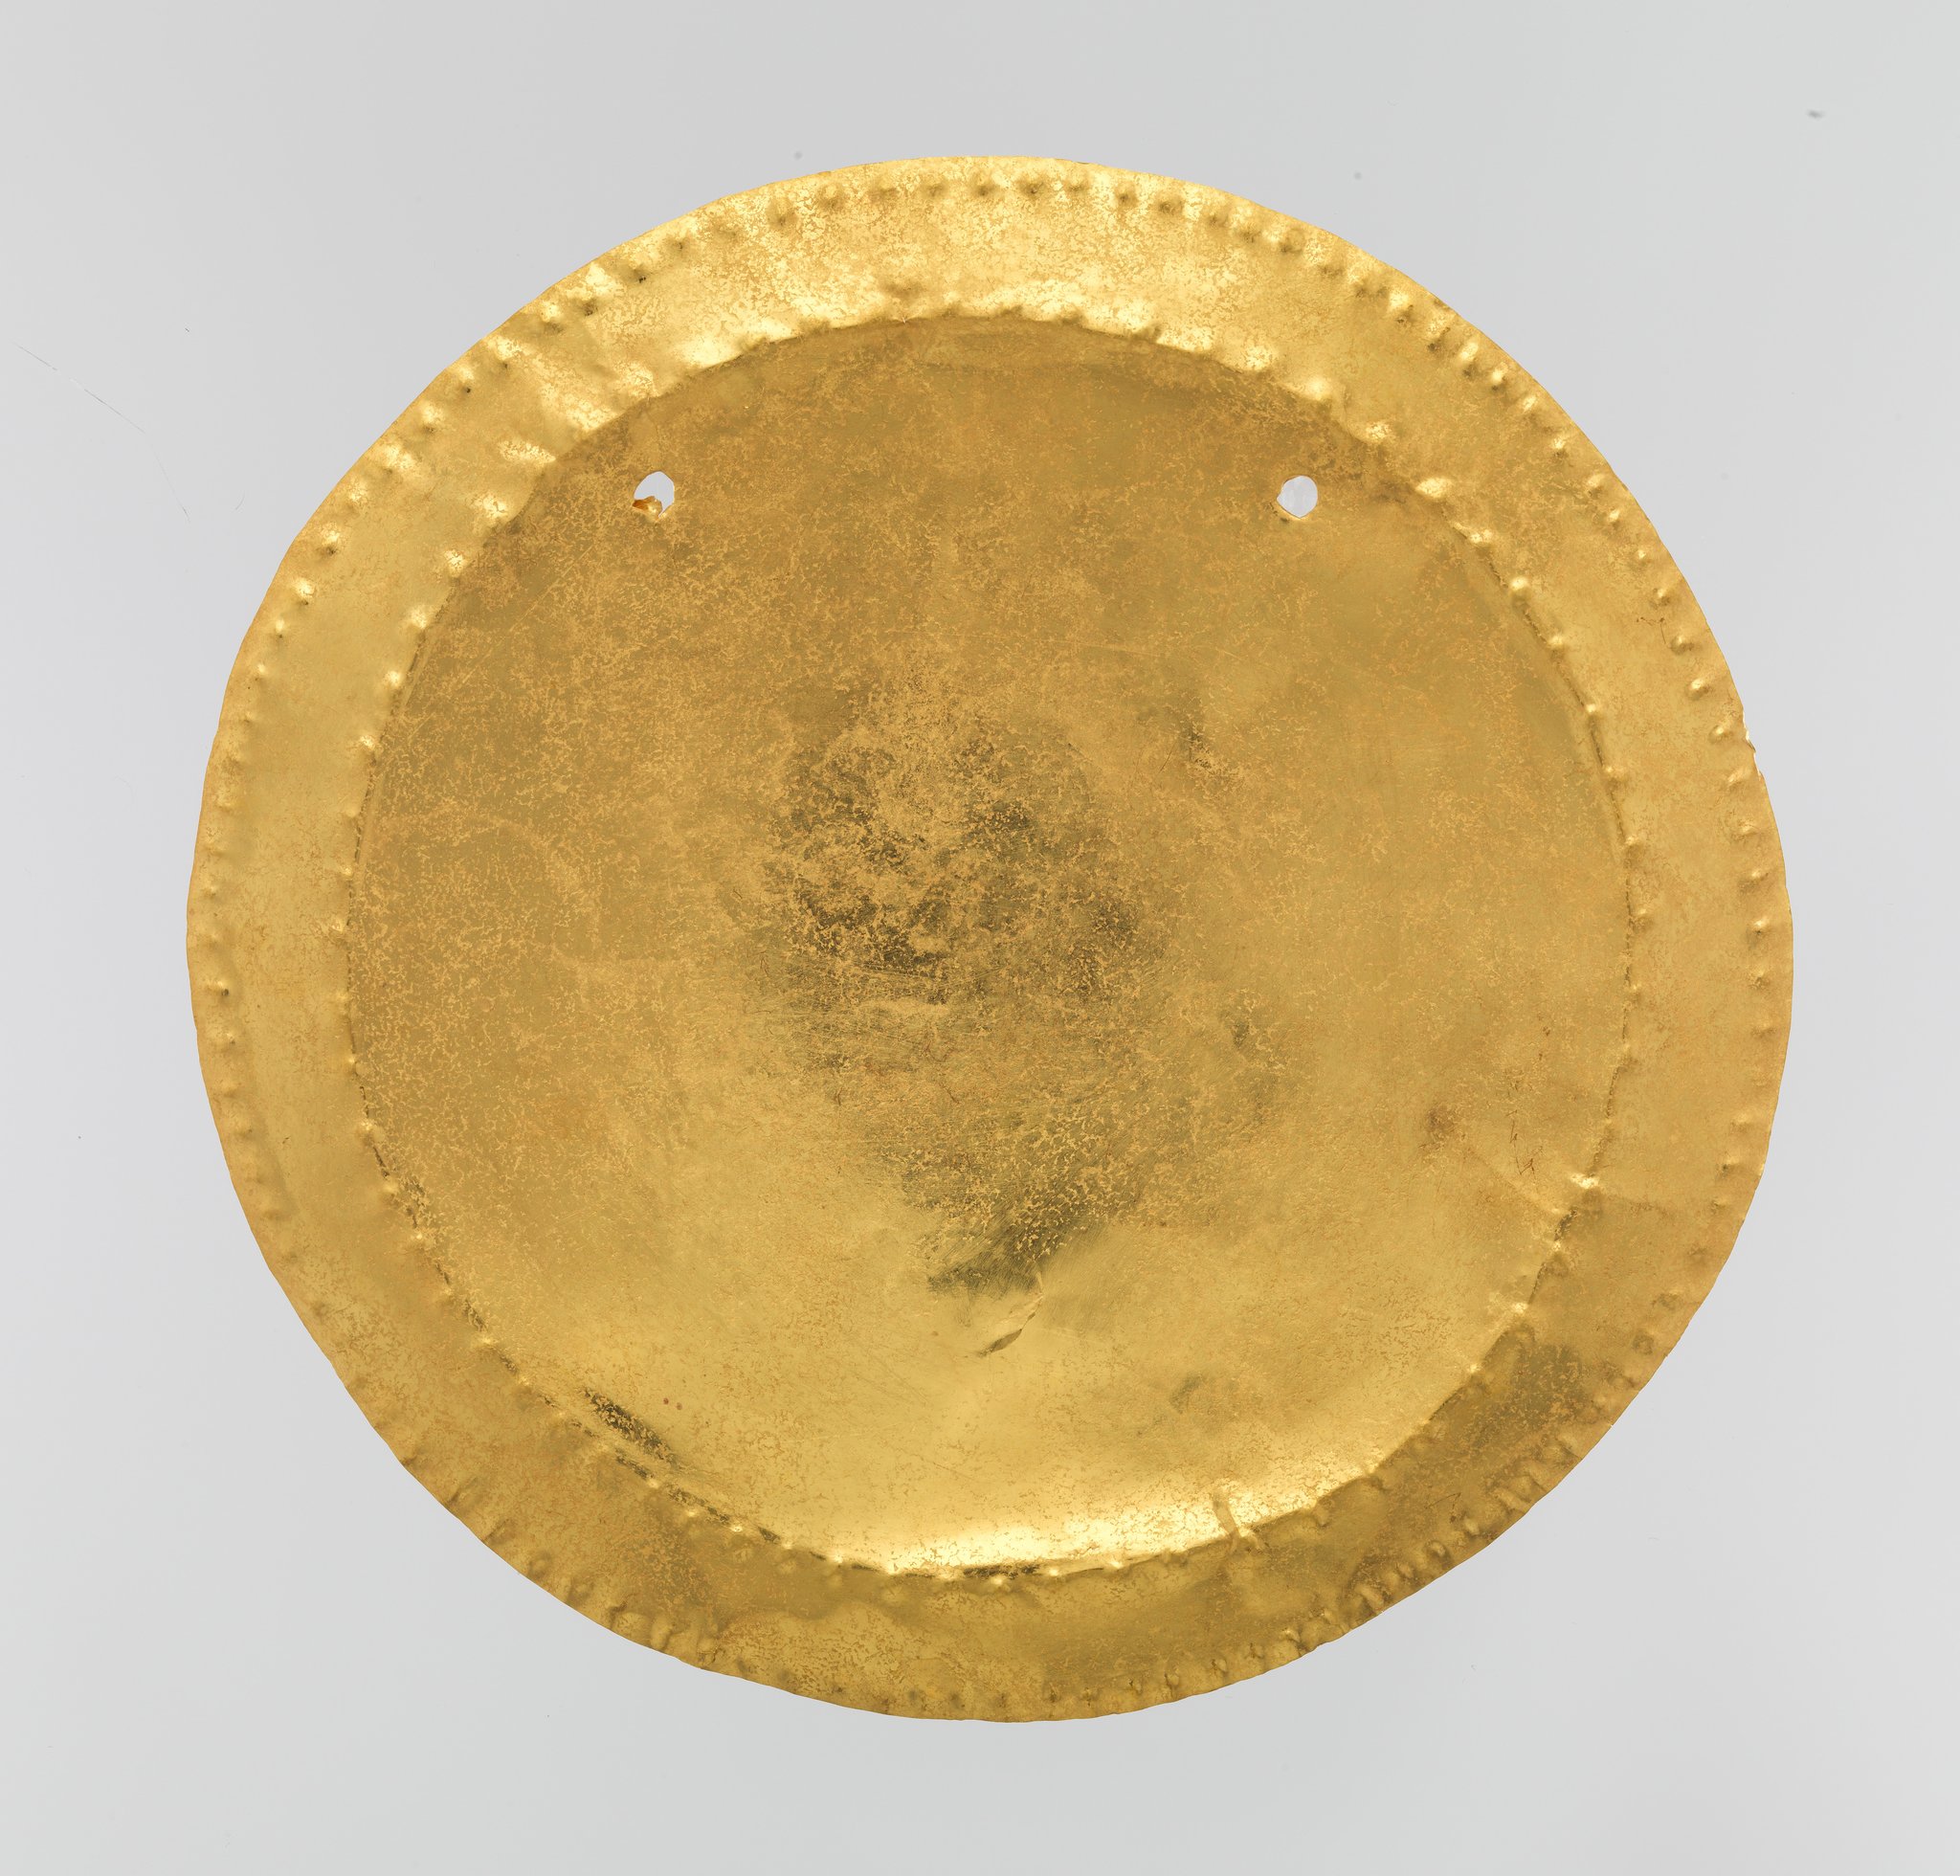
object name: pectoral disk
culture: coclé, macaracas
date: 701-1200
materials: gold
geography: panama